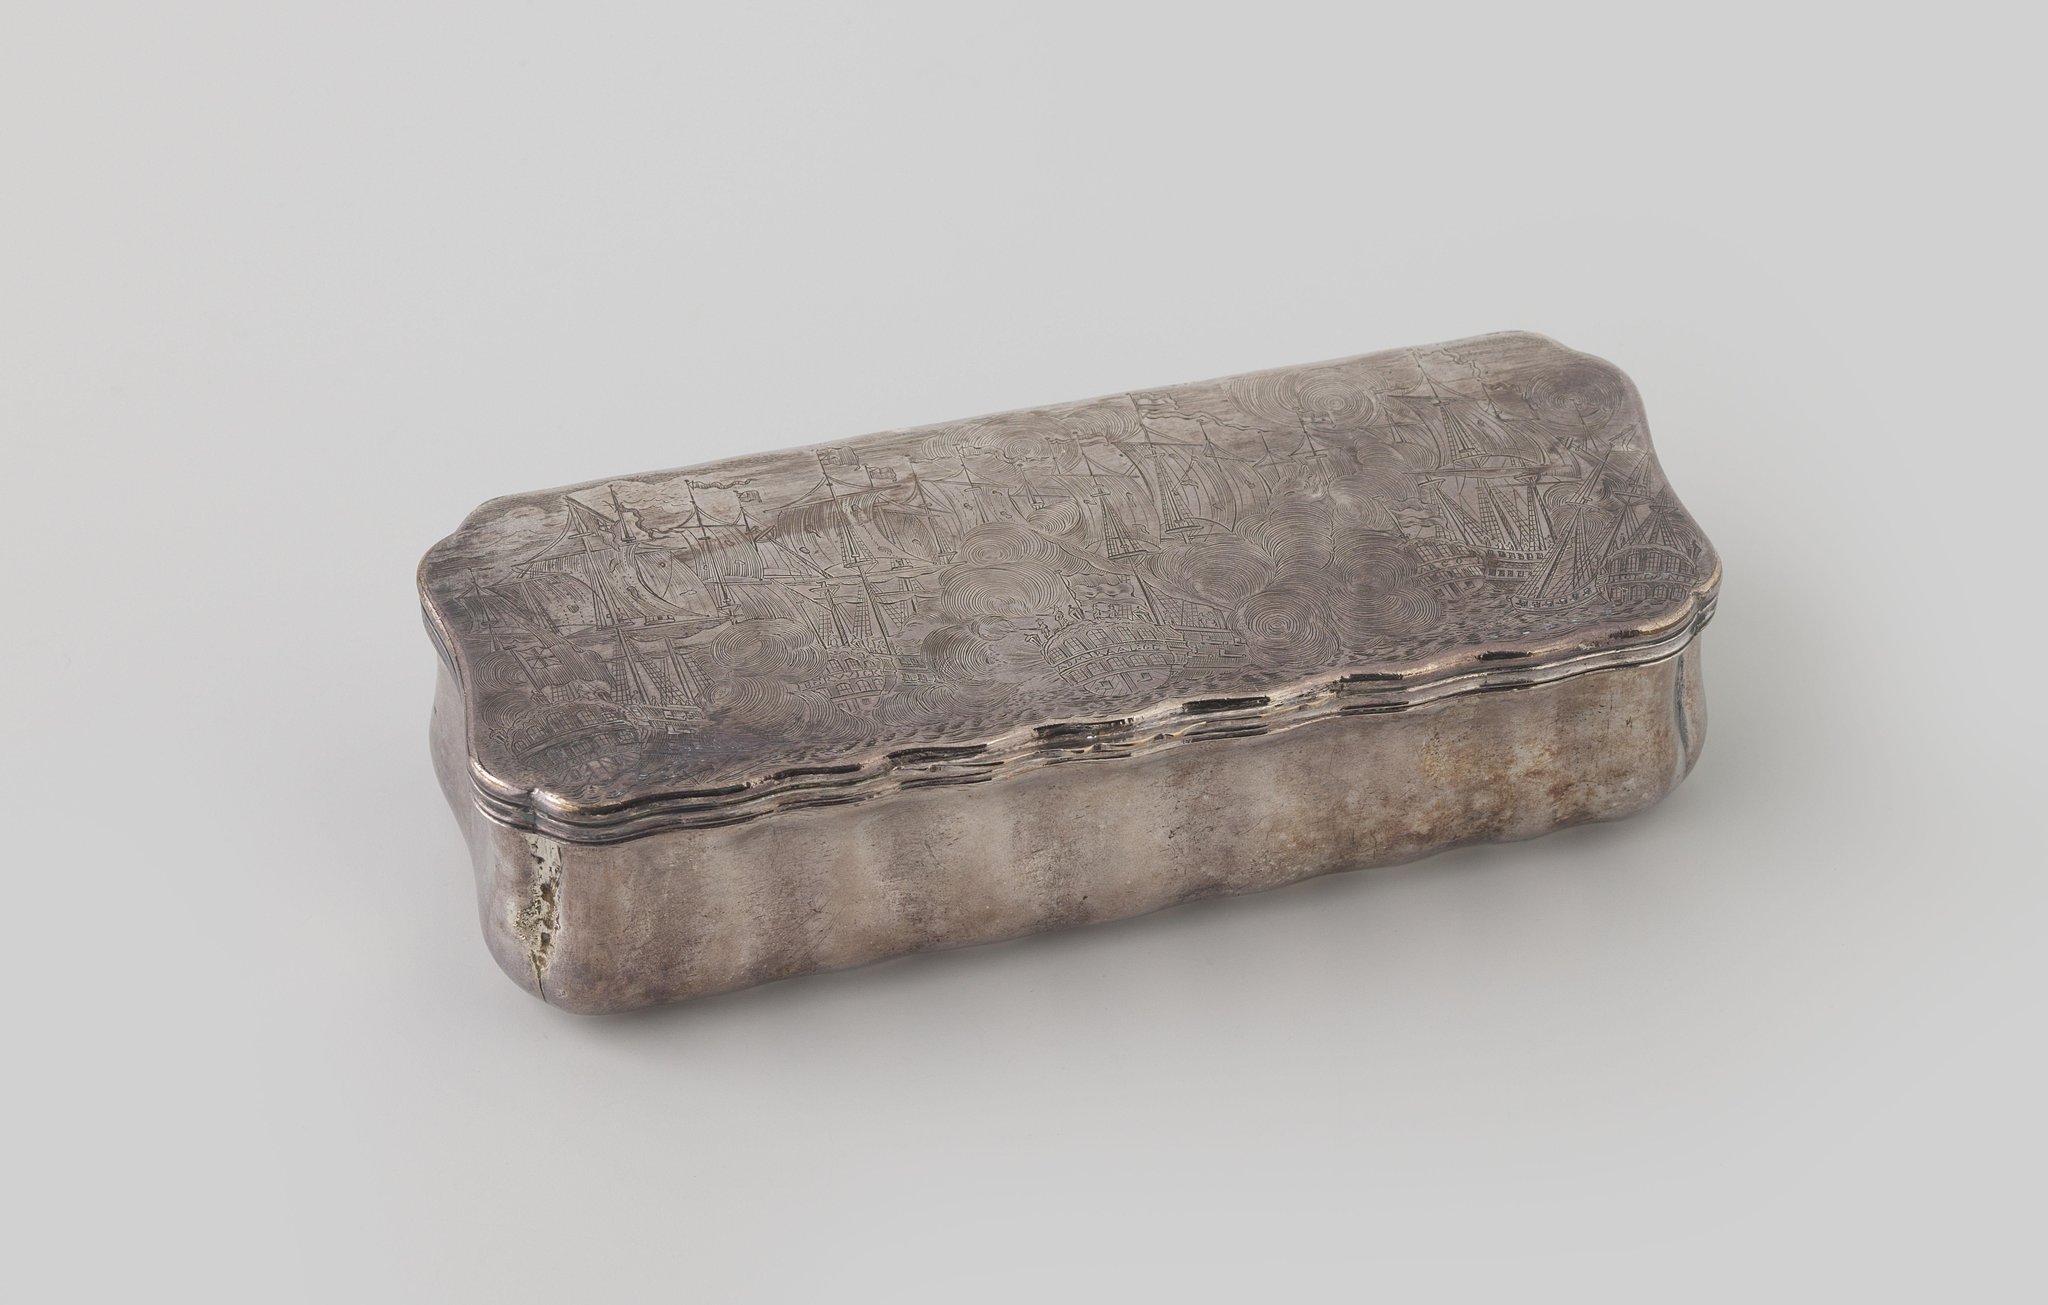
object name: tobacco box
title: Slag bij Doggersbank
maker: justus van den berg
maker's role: silversmith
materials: silver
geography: leeuwarden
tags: the hague, johan arnold zoutman, hyde parker, battle (+ sailing-ships)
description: Zilveren tabaksdoos met gegolfde zijkanten. Op de deksel staat een zeeslag afgebeeld; van vijf schepen is de naam op de spiegel leesbaar, v.l.n.r.: De FORTITUDE / BERWICK / ADMIRAAL:GE / ARGO / HOLLAND. Op de bodem tussen bloemmotieven en rocaille het opschrift.